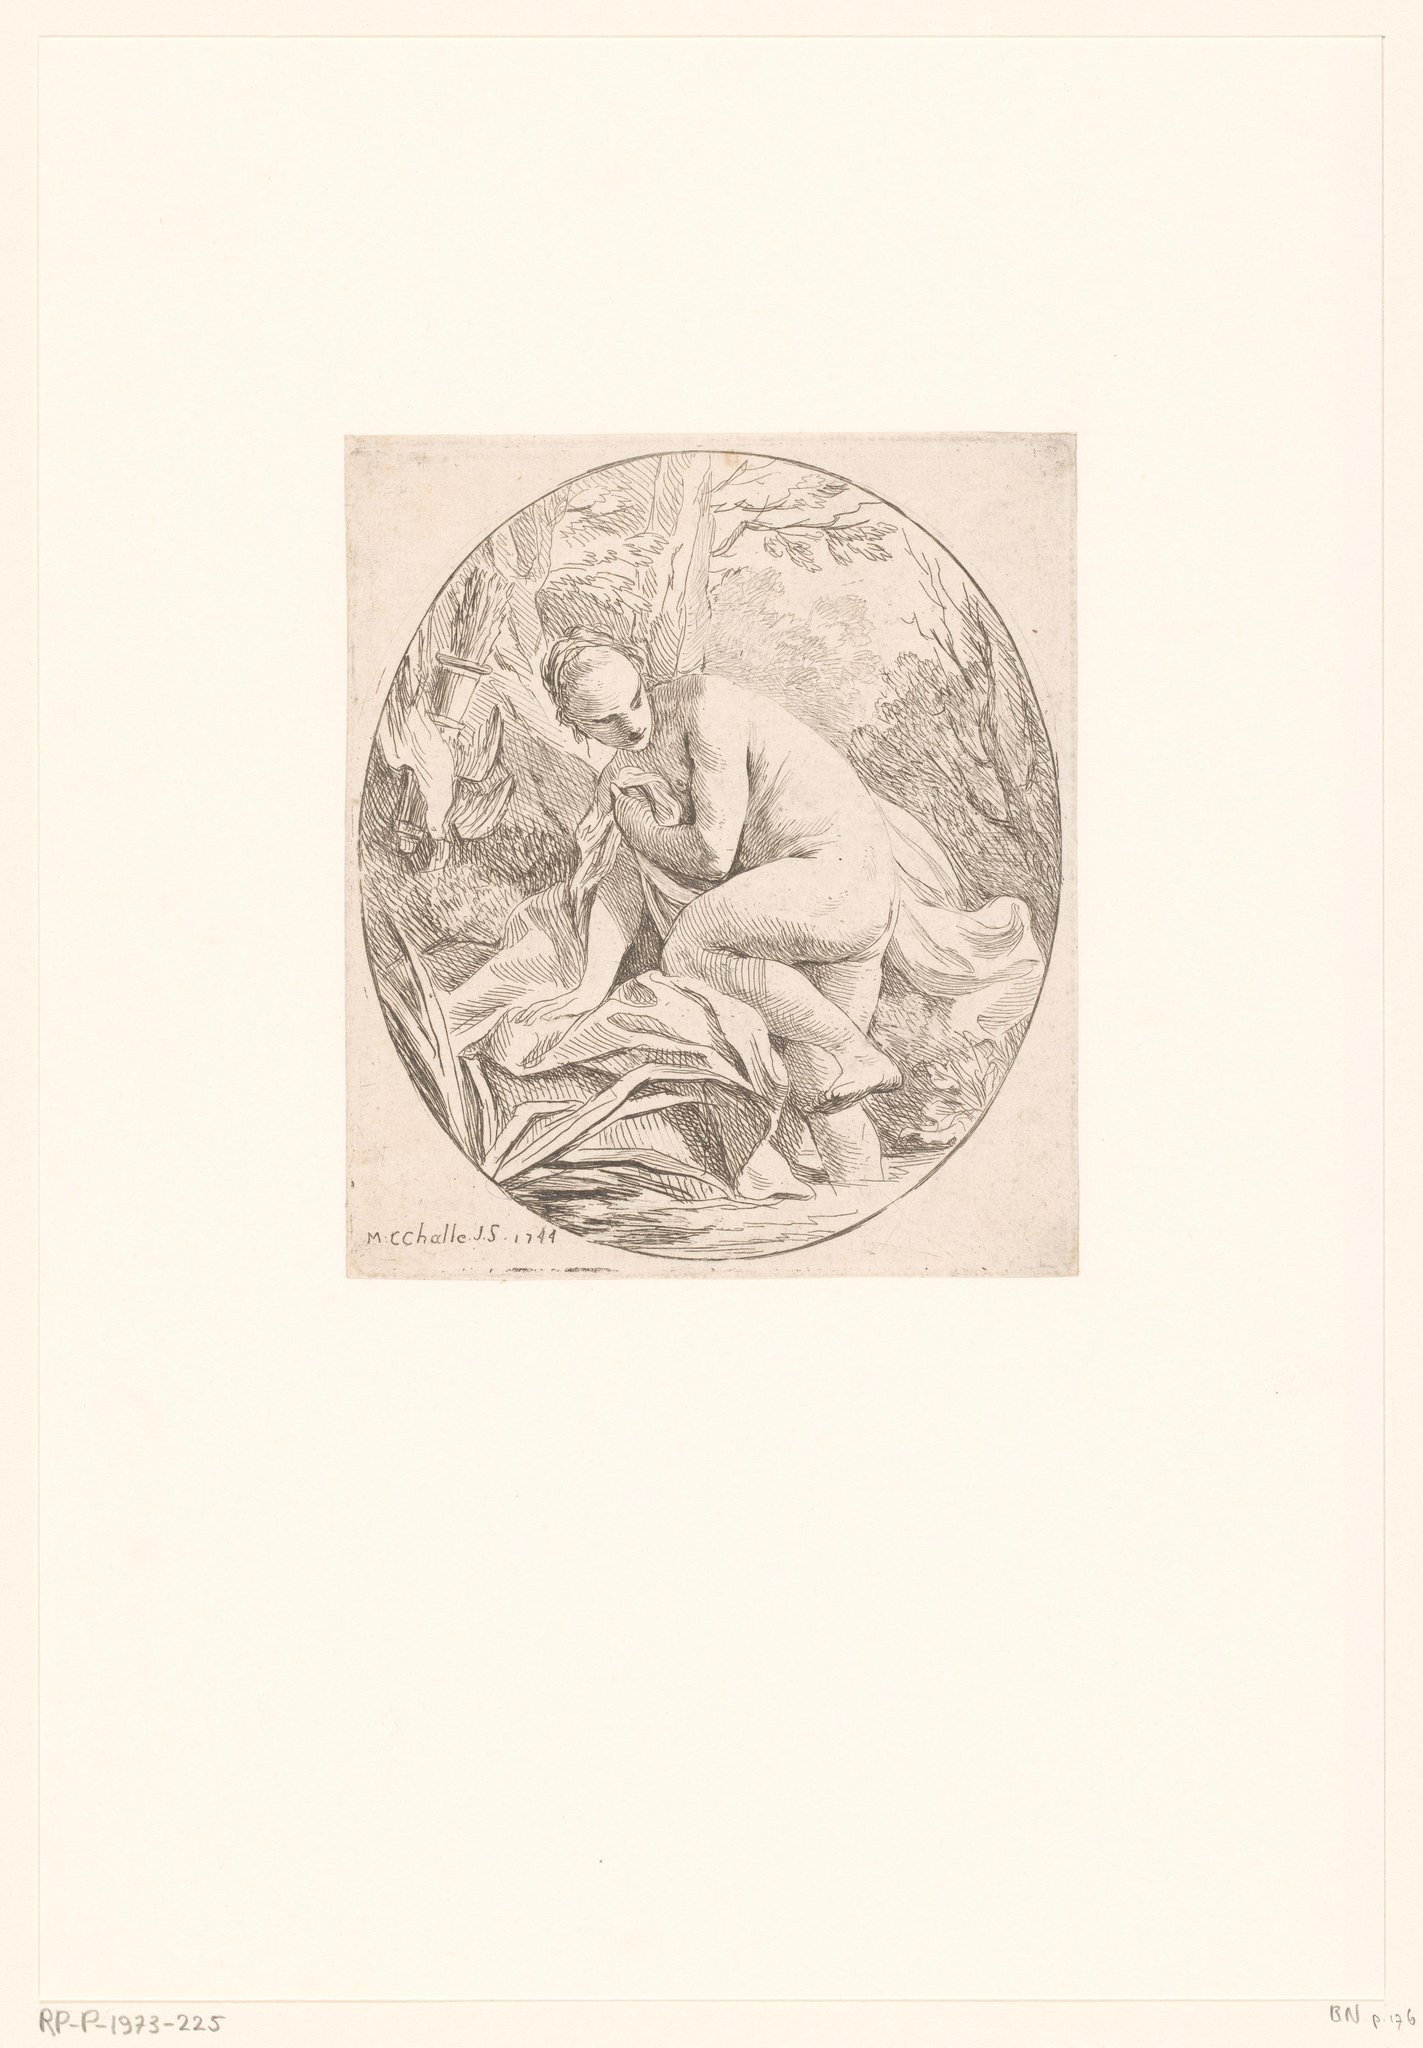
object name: print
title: Badende Diana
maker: charles michel-ange challe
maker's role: draughtsman, print maker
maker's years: 1718-1778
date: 1744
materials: paper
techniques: etching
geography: paris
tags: diana bathing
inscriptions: collector's mark: Lugt 2760, collector's mark: Lugt 2228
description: Betreft de pendant van een badende nimf, eveneens in een ovaal door Challe. Beide prenten zijn 1744 gedateerd. De pendant bevindt zich o.a. in de collectie van het Metropolitan Museum of Art te New York, inv.nr. 53.523.6.